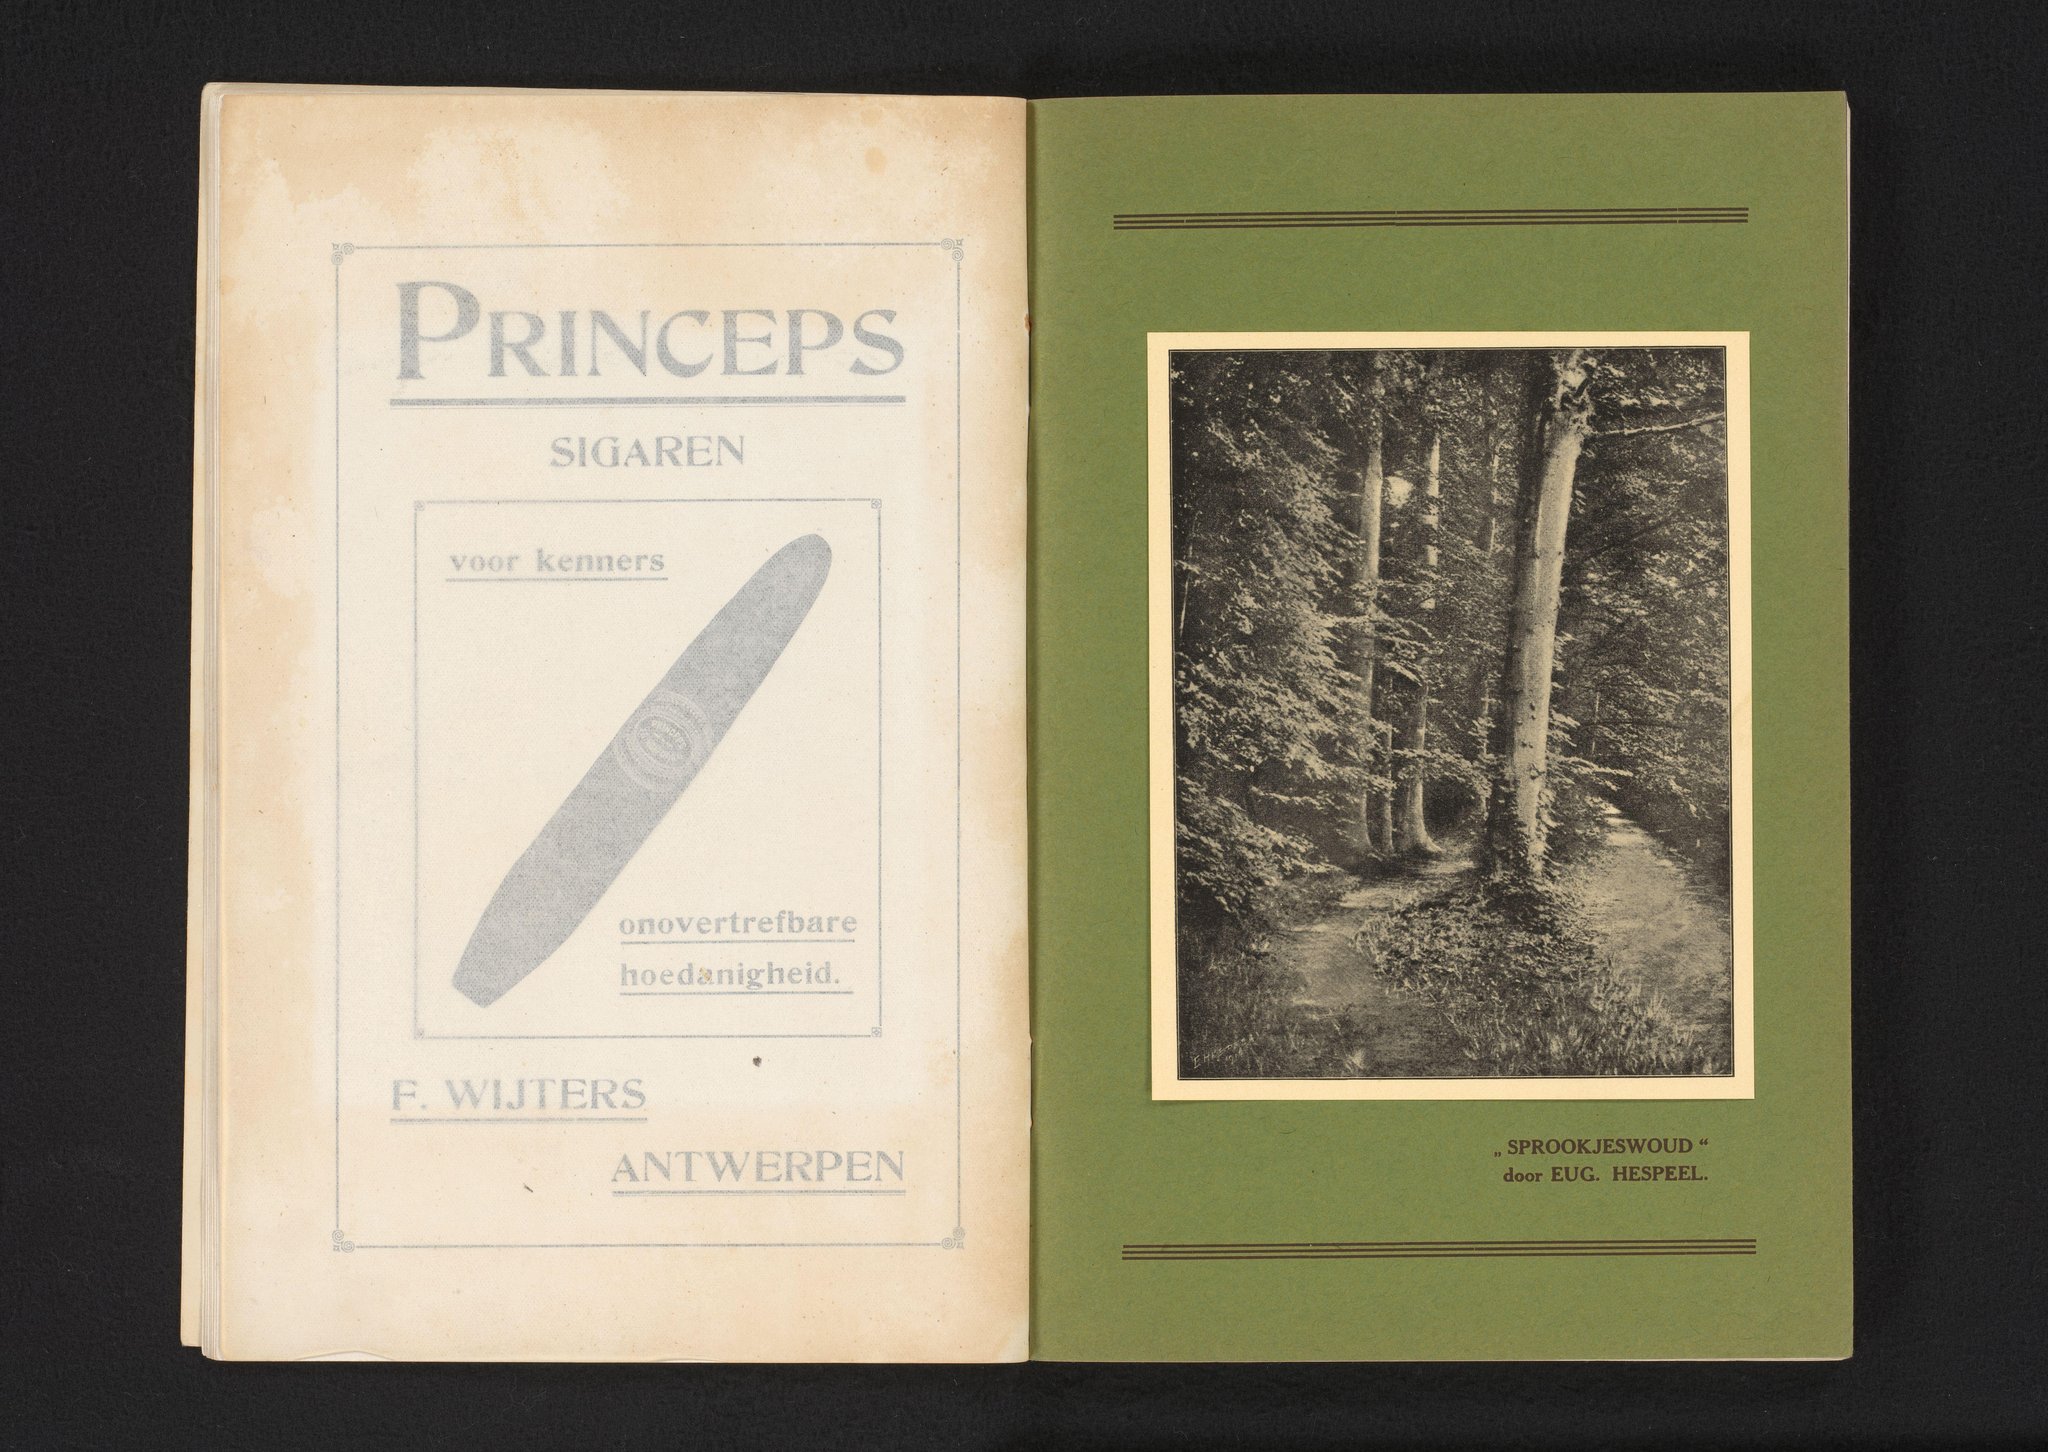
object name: page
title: Gezicht op een bos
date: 1911-1916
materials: paper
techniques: autotype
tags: forest, wood